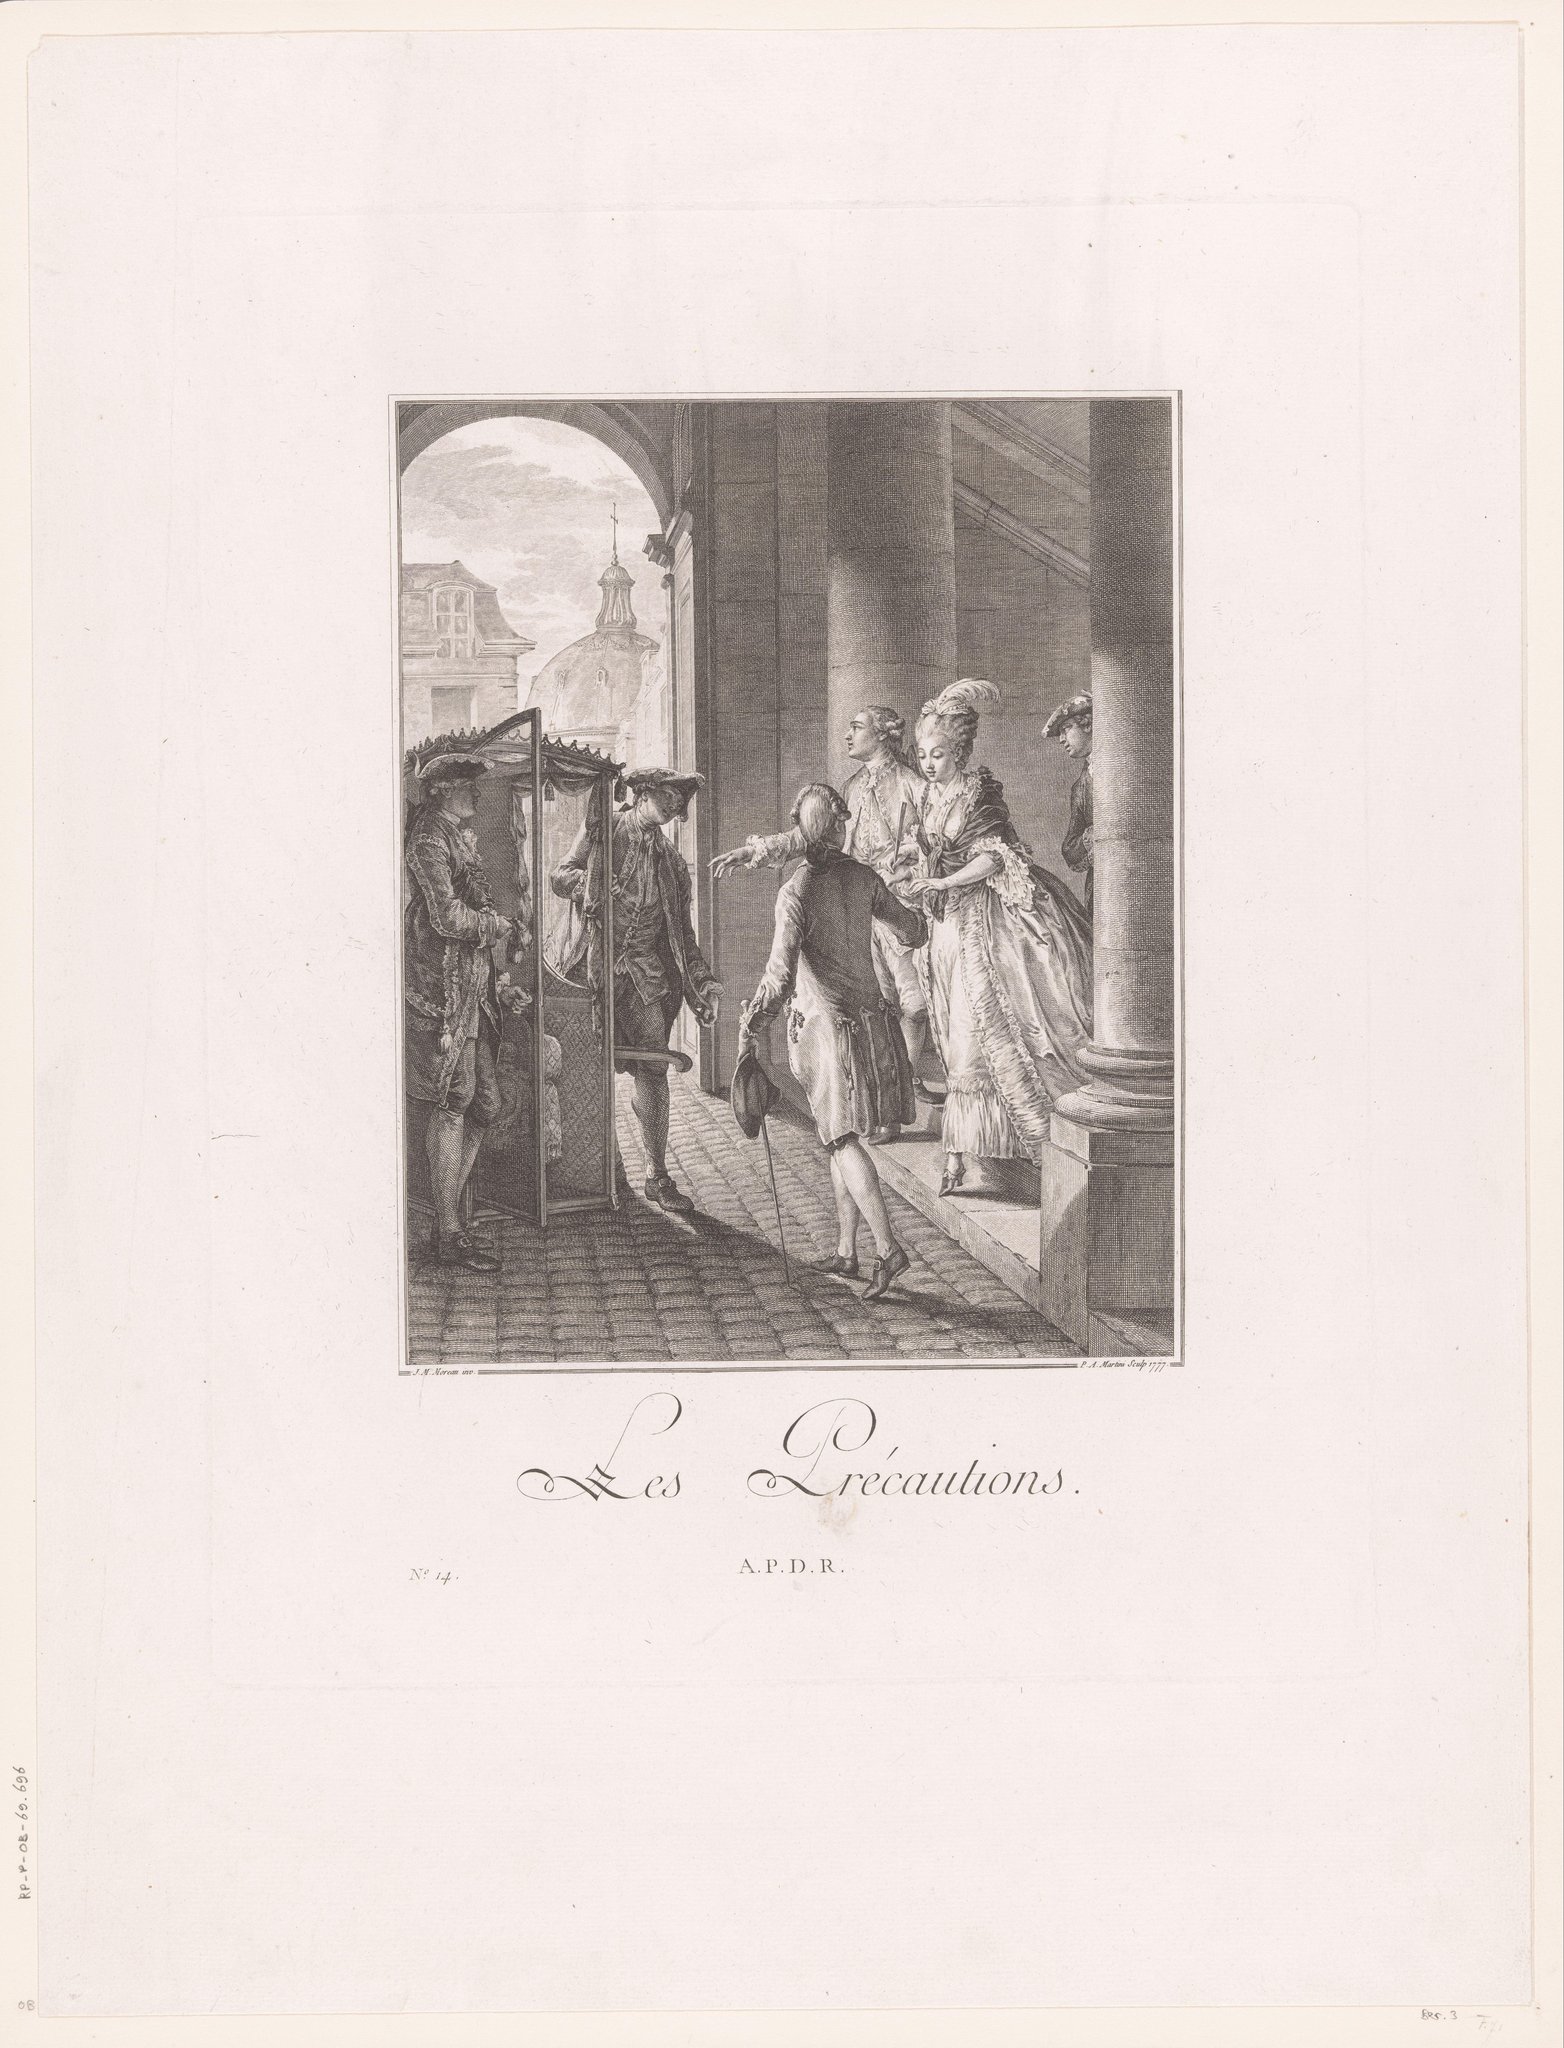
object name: print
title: Voorzorgsmaatregelen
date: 1777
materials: paper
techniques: engraving, etching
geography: france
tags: head-gear: tricorn (+ men's clothes), clothing for the upper part of the body (+ women's clothes), ensembles of pieces of clothing (habit à la française) (+ men's clothes), (carrying a person in a) sedan-chair, clothes, costume (+ women's clothes), dress, gown (+ women's clothes), clothes, costume (+ men's clothes), pregnant woman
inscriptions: collector's mark: Lugt 2228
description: De elegant geklede zwangere Céphise loopt voorzichtig de trap van een woonhuis af. Zij draagt een japon met 'engageantes' waarover een kleine schoudermantel. Een heer reikt haar de hand om in een openstaande draagstoel te stappen. De mannen dragen een 'habit à la française' met gerimpeld jabot en manchetten. De staart van het haar (de pruik ?) in een haarzak met strik; driekantige steek als hoed. De dunne wandelstok heeft de galadegen vervangen.